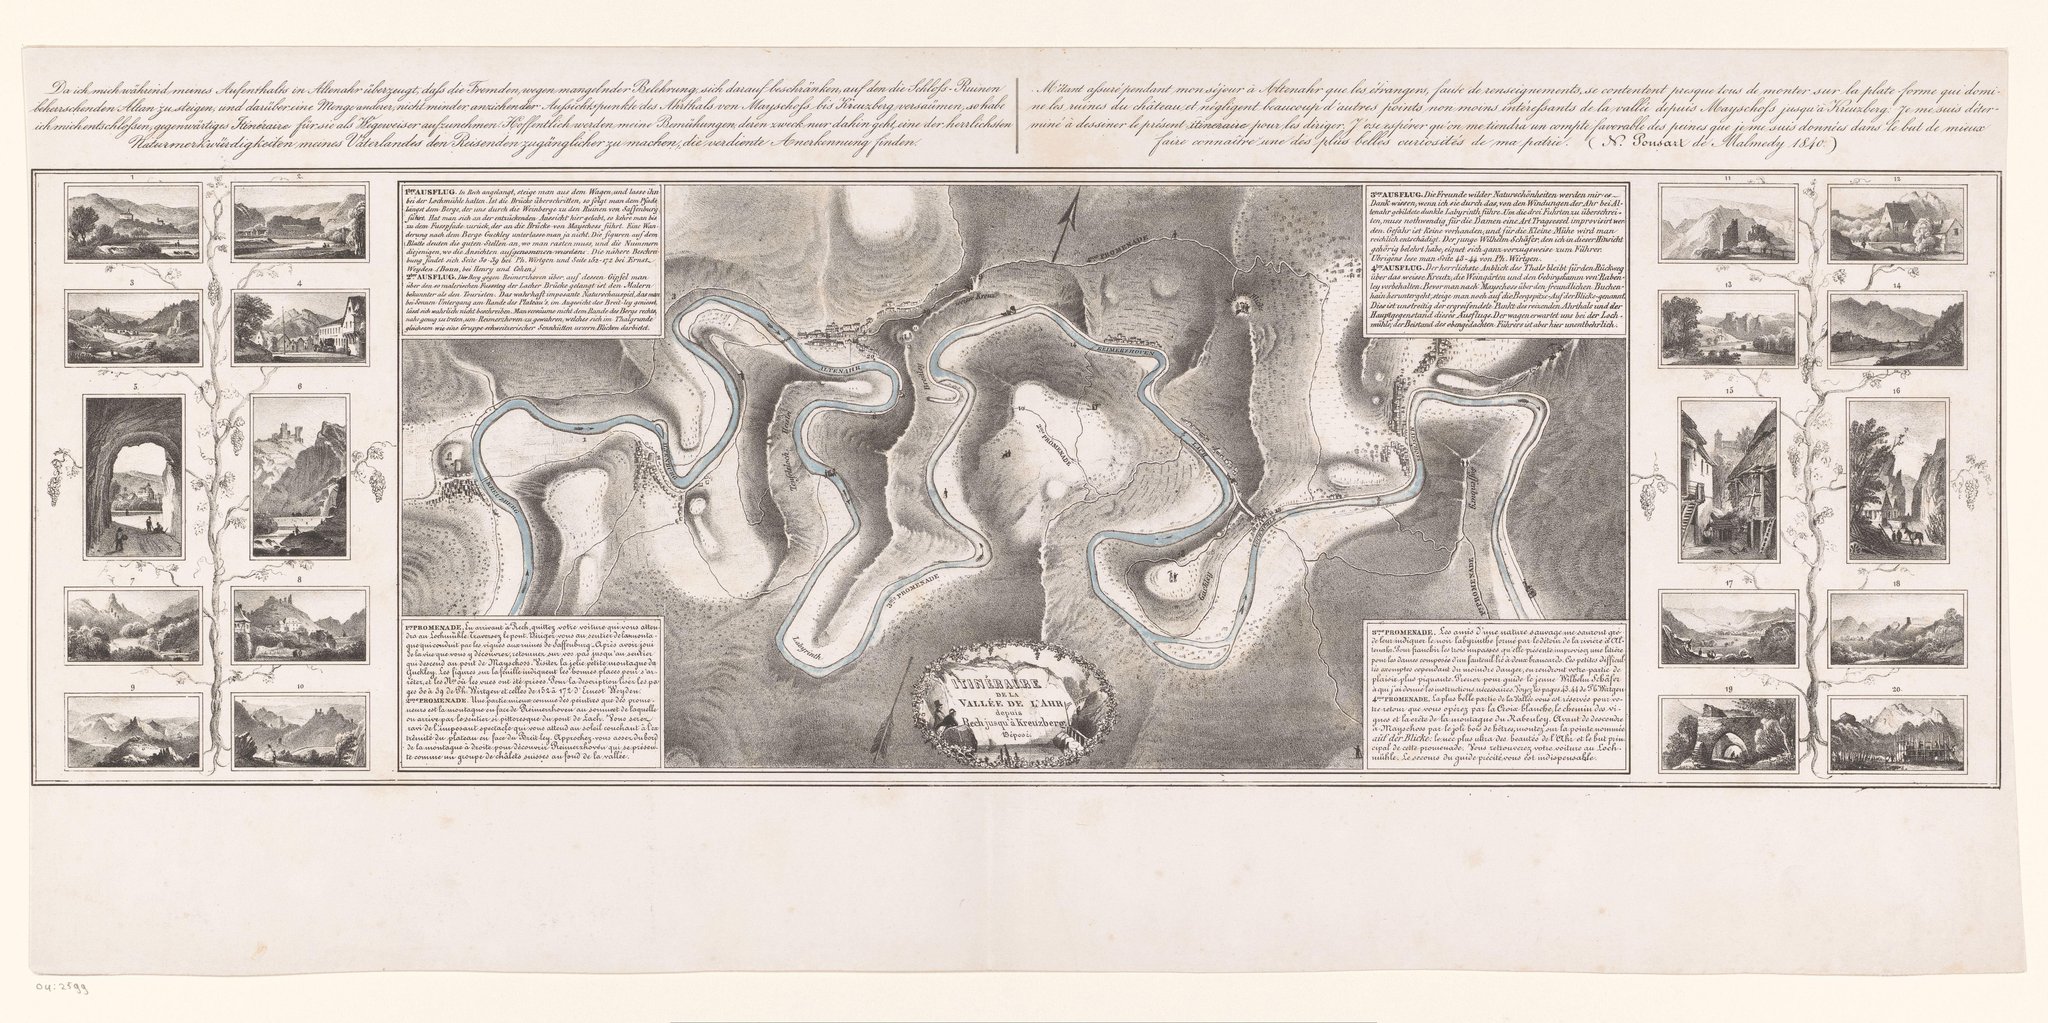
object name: print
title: Itinéraire de la Vallée de l'Ahr depuis Rech jusqu'à Kreuzberg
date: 1840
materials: paper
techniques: hand coloring, lithograph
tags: city-view, and landscape with man-made constructions, landscapes, river, maps, atlases, switzerland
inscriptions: : ‘Déposé’, collector's mark: Lugt 2228, mark: ‘1.Thale[n]’